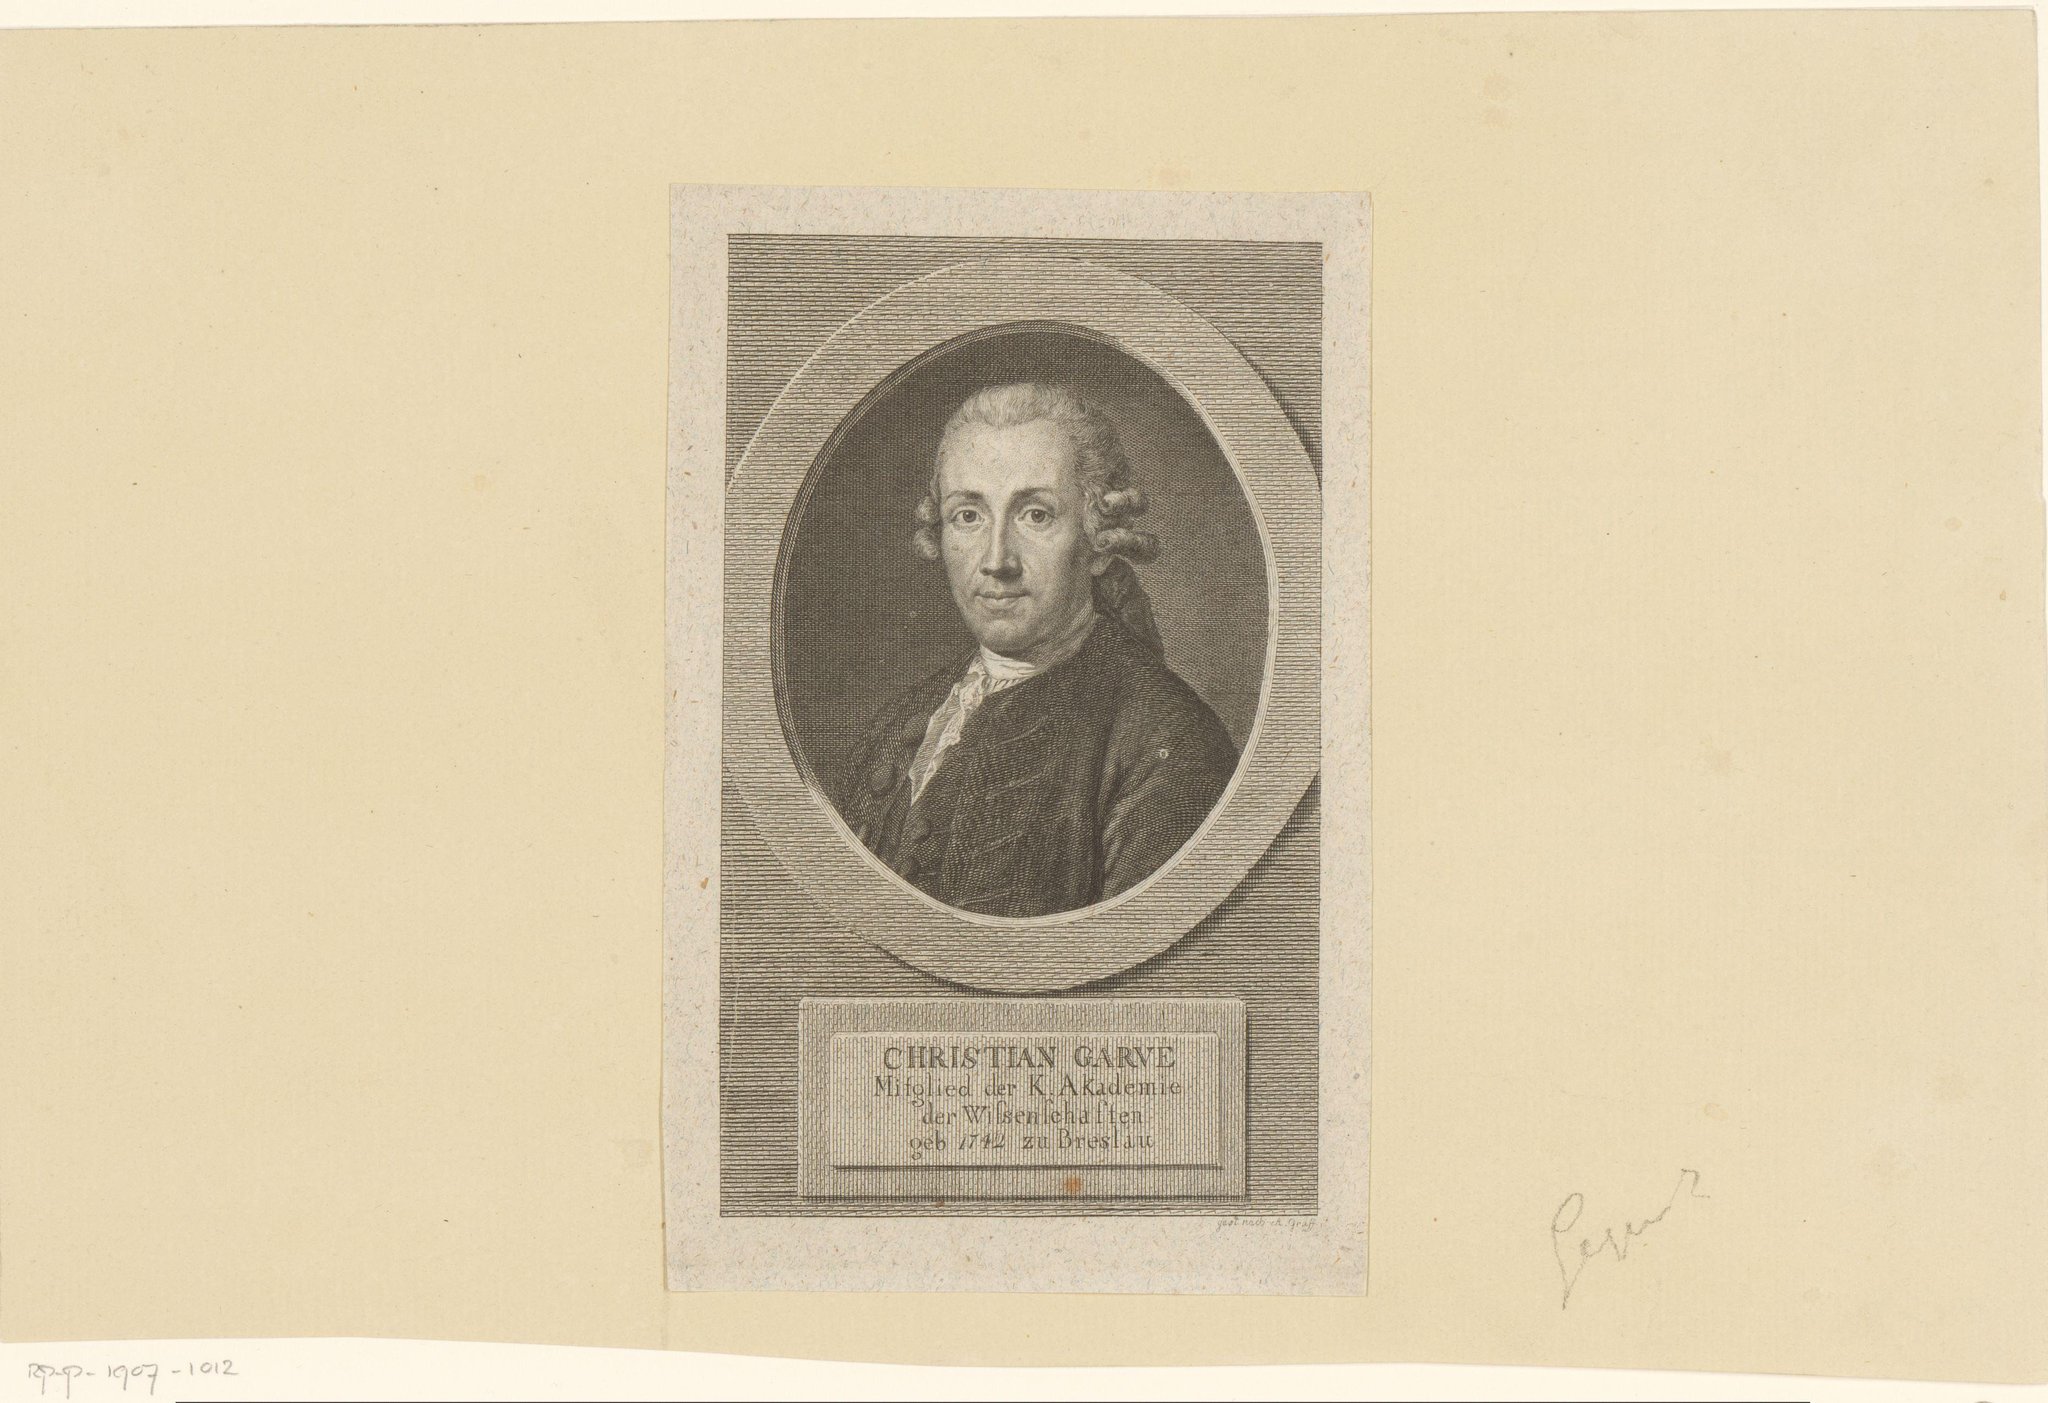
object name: print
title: Portret van Rudolf Füssli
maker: johann rudolph schellenberg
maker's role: print maker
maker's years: 1740-1806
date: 1771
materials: paper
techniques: etching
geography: vienna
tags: vienna, print maker, historical persons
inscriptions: collector's mark: Lugt 2228